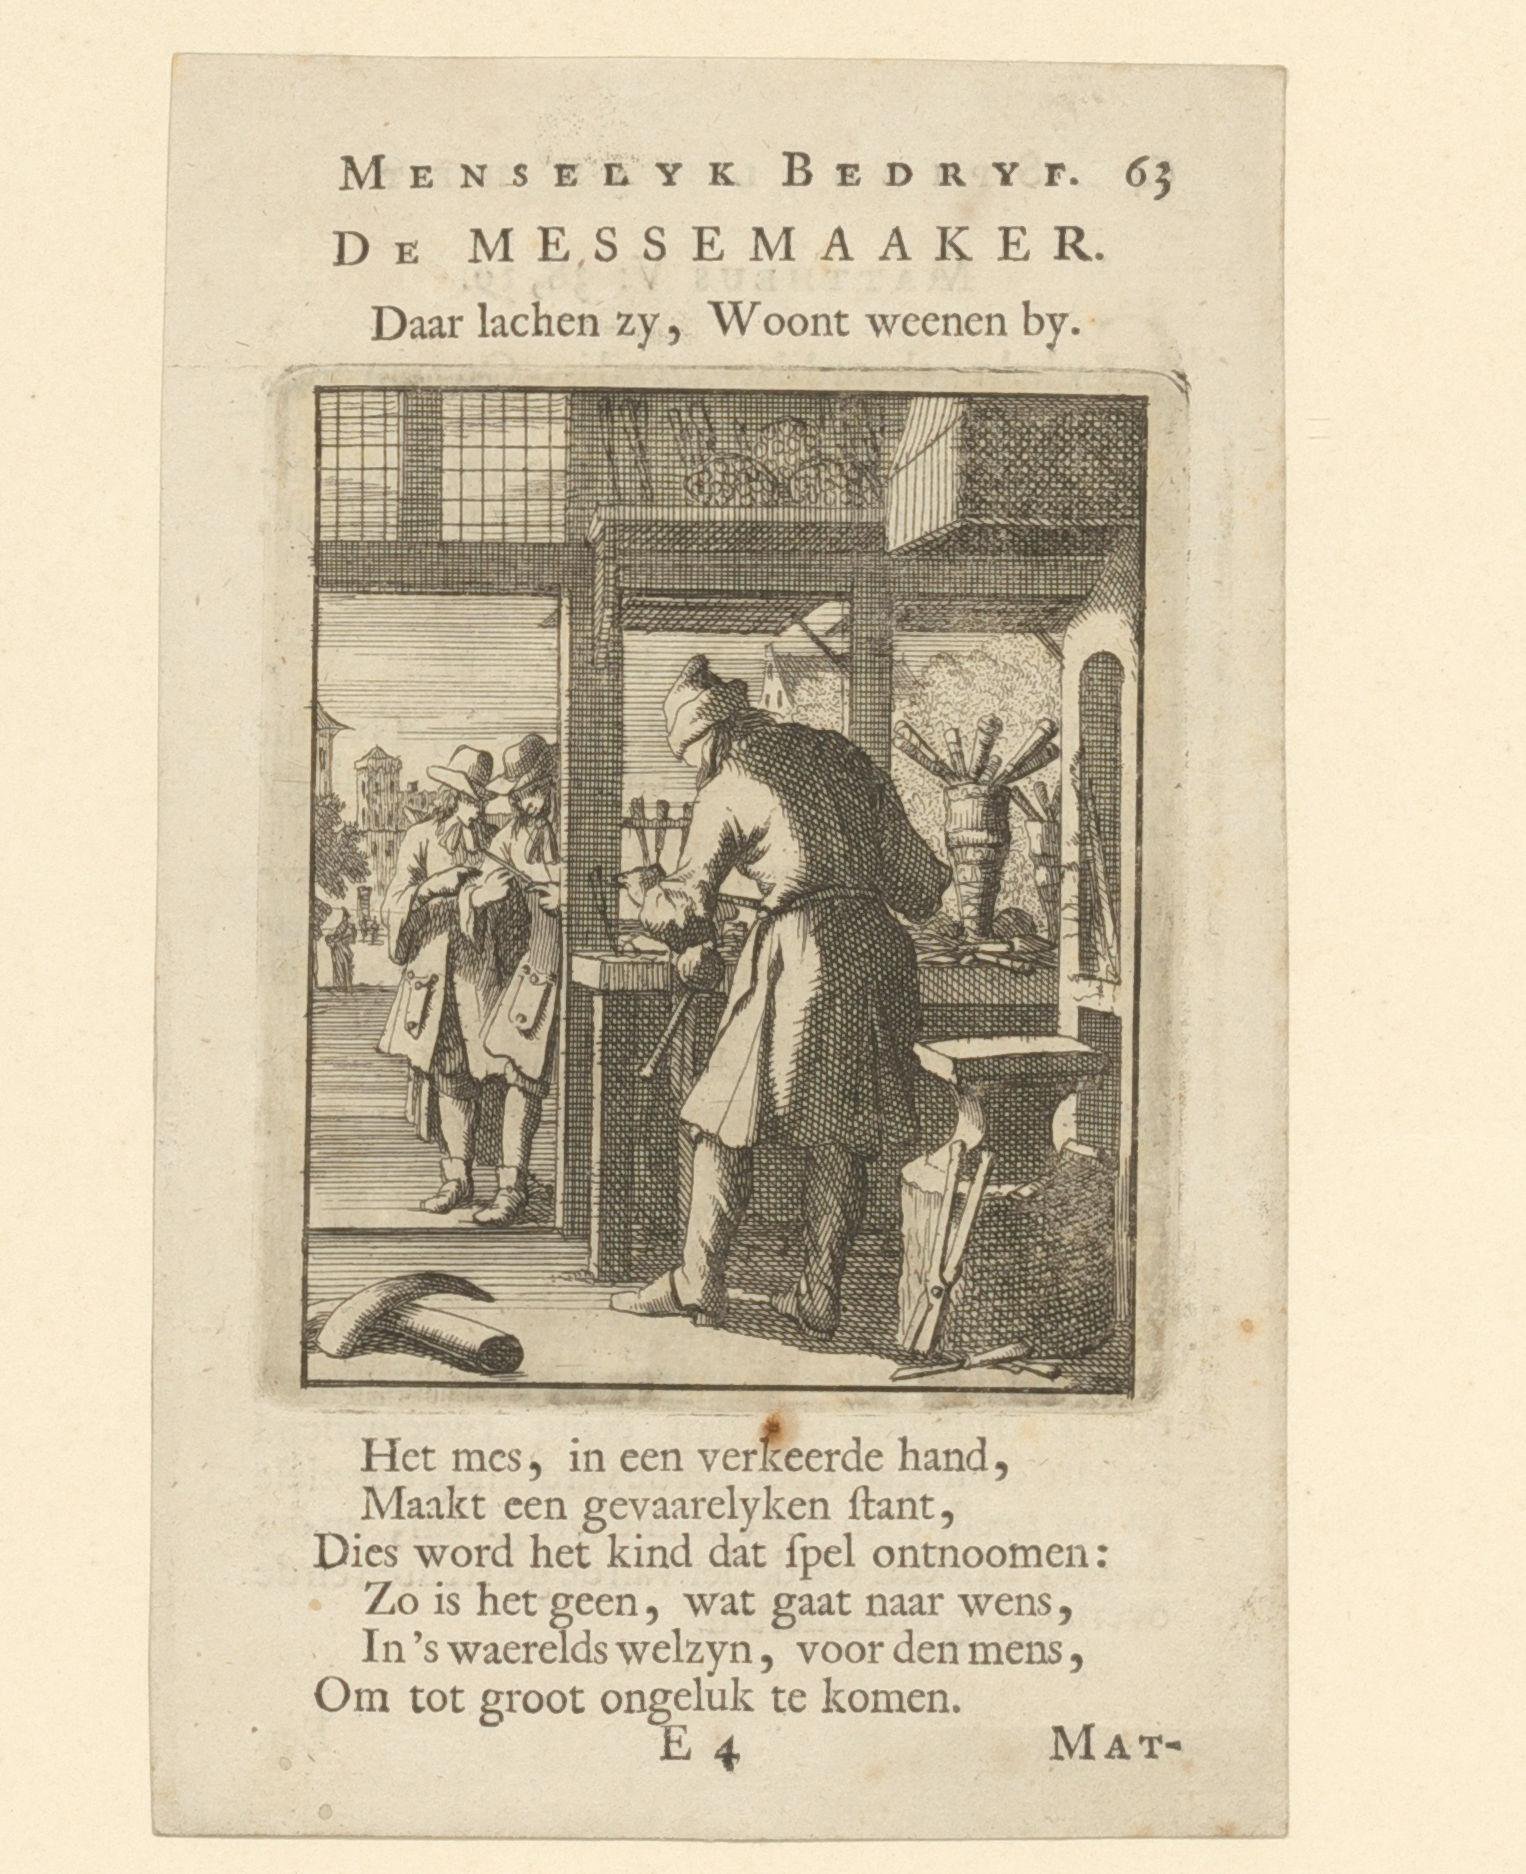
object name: print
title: De Messemaaker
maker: cornelis van der sys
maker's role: publisher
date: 1718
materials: paper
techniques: etching, letterpress printing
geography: amsterdam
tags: handicrafts, craftsman at work, tools, aids, implements ~ crafts and industries: knife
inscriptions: collector's mark: Lugt 1641, stamp, stamp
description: Prent oorspronkelijk verschenen in de 100-delige serie beroepsprenten van Jan en Caspar Luyken, getiteld: Het menselyk bedryf. S.l.s.n., 1694 (eerste druk). Daarna is de titel en het vers afgesneden. De prenten in diverse publicaties verschenen en gekopieerd. Huidige staat uit: Luyken, Jan en Caspar. Spiegel van het menselyk bedryf (...). Amsterdam: Cornelis van der Sys, 1718, p. 63. Prent waarschijnlijk ook gebruikt in eerdere (1704) en latere (1730, 1749, 1767) publicaties.